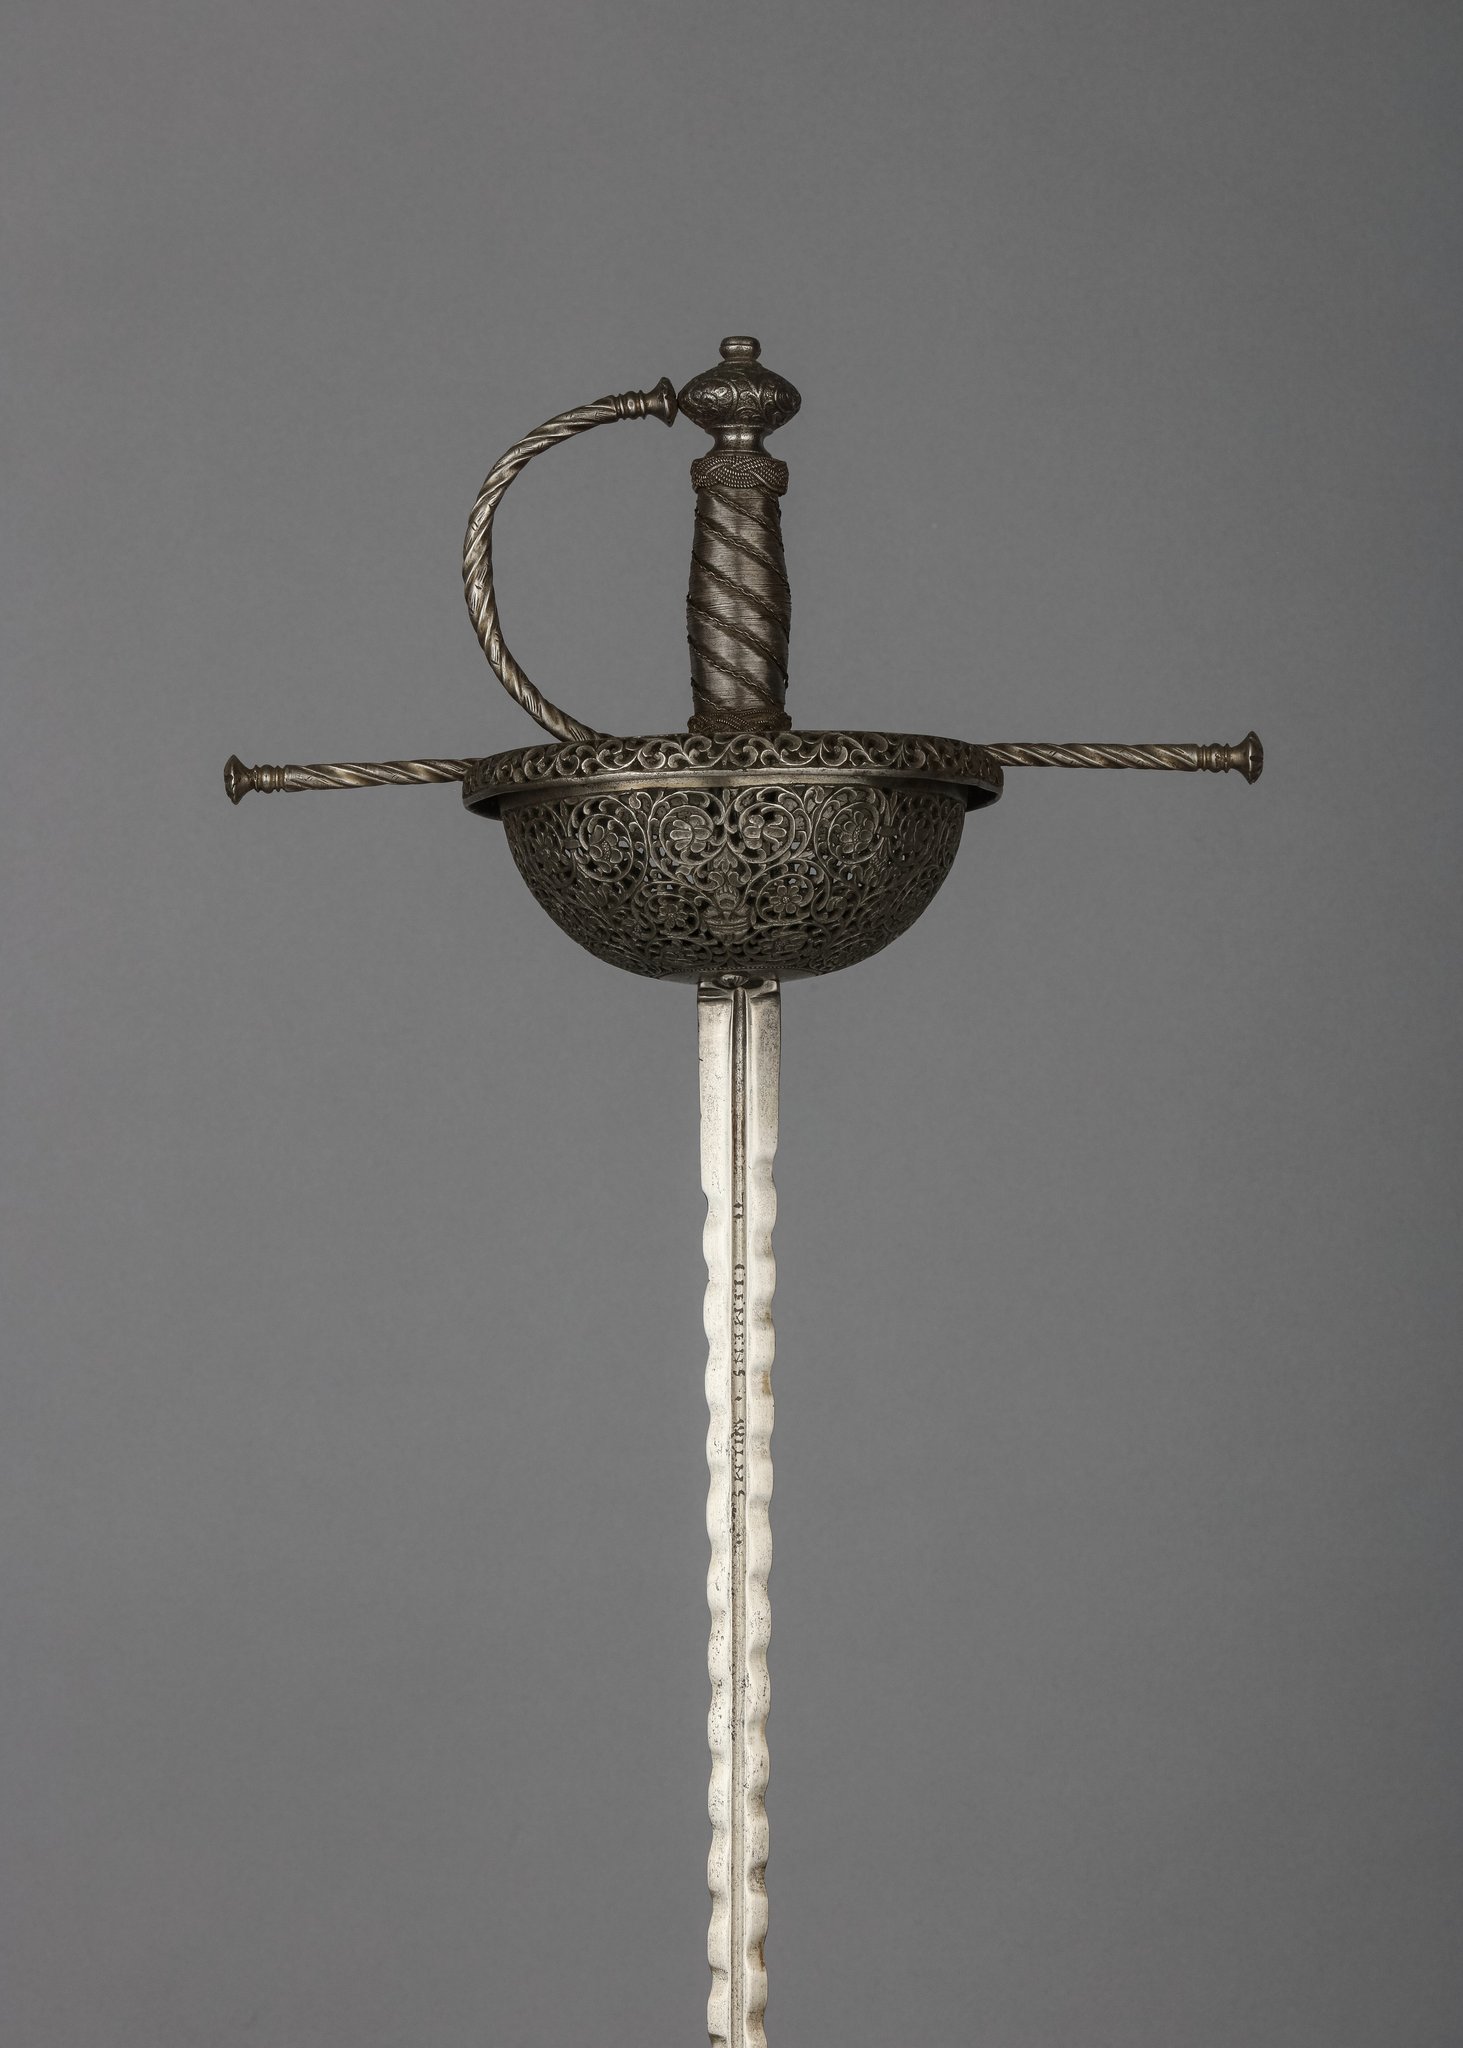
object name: cup hilted rapier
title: Cup-Hilted Rapier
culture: german or spanish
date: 1650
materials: iron, steel, wood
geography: germany